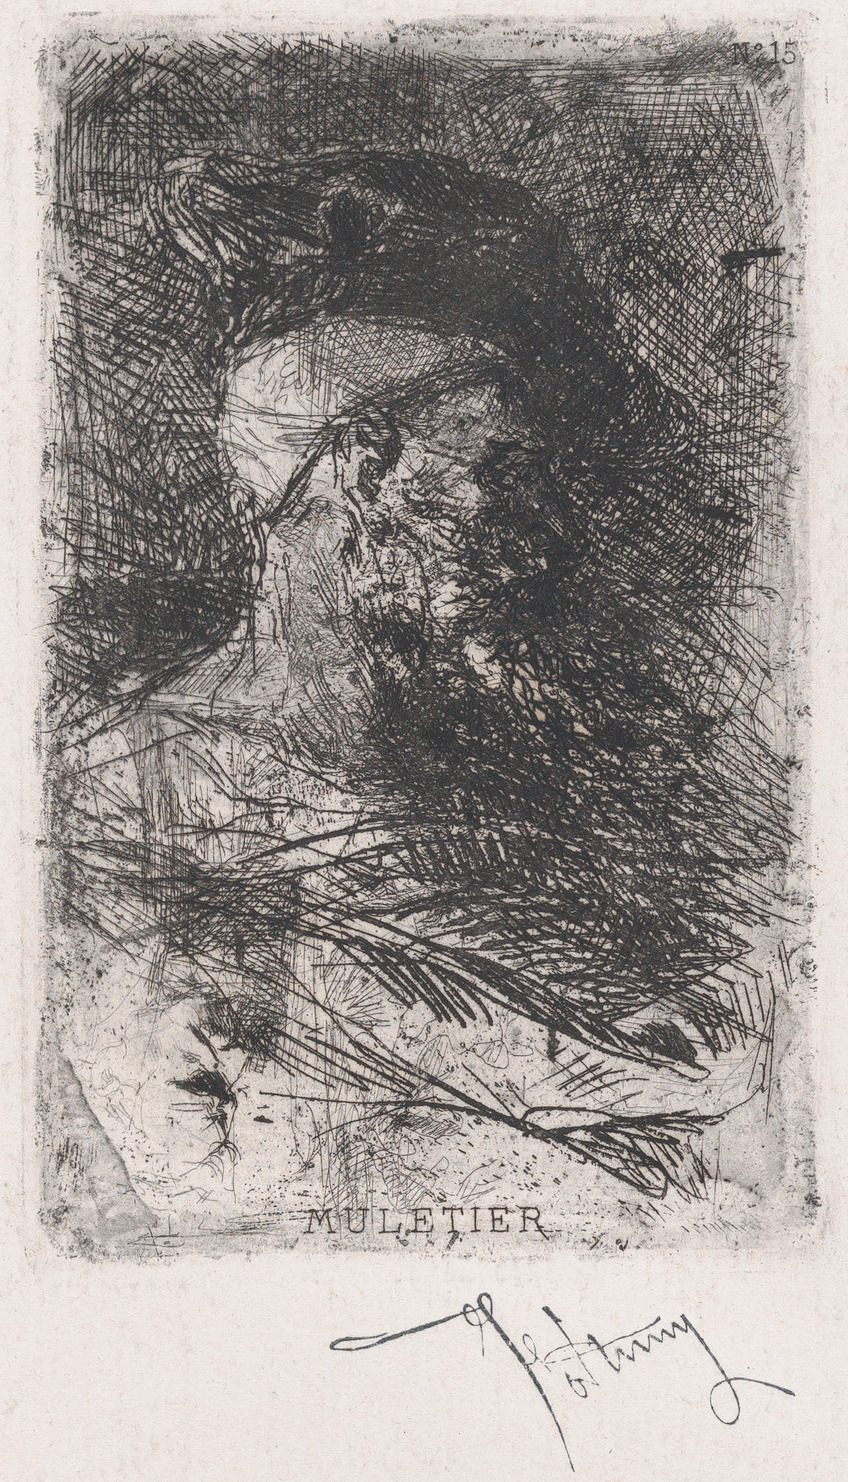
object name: print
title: Head of a muleteer facing right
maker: mariano fortuny, 1838–1874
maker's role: artist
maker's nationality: spanish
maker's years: 1838-1874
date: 1860-1870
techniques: etching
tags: heads,men,profiles